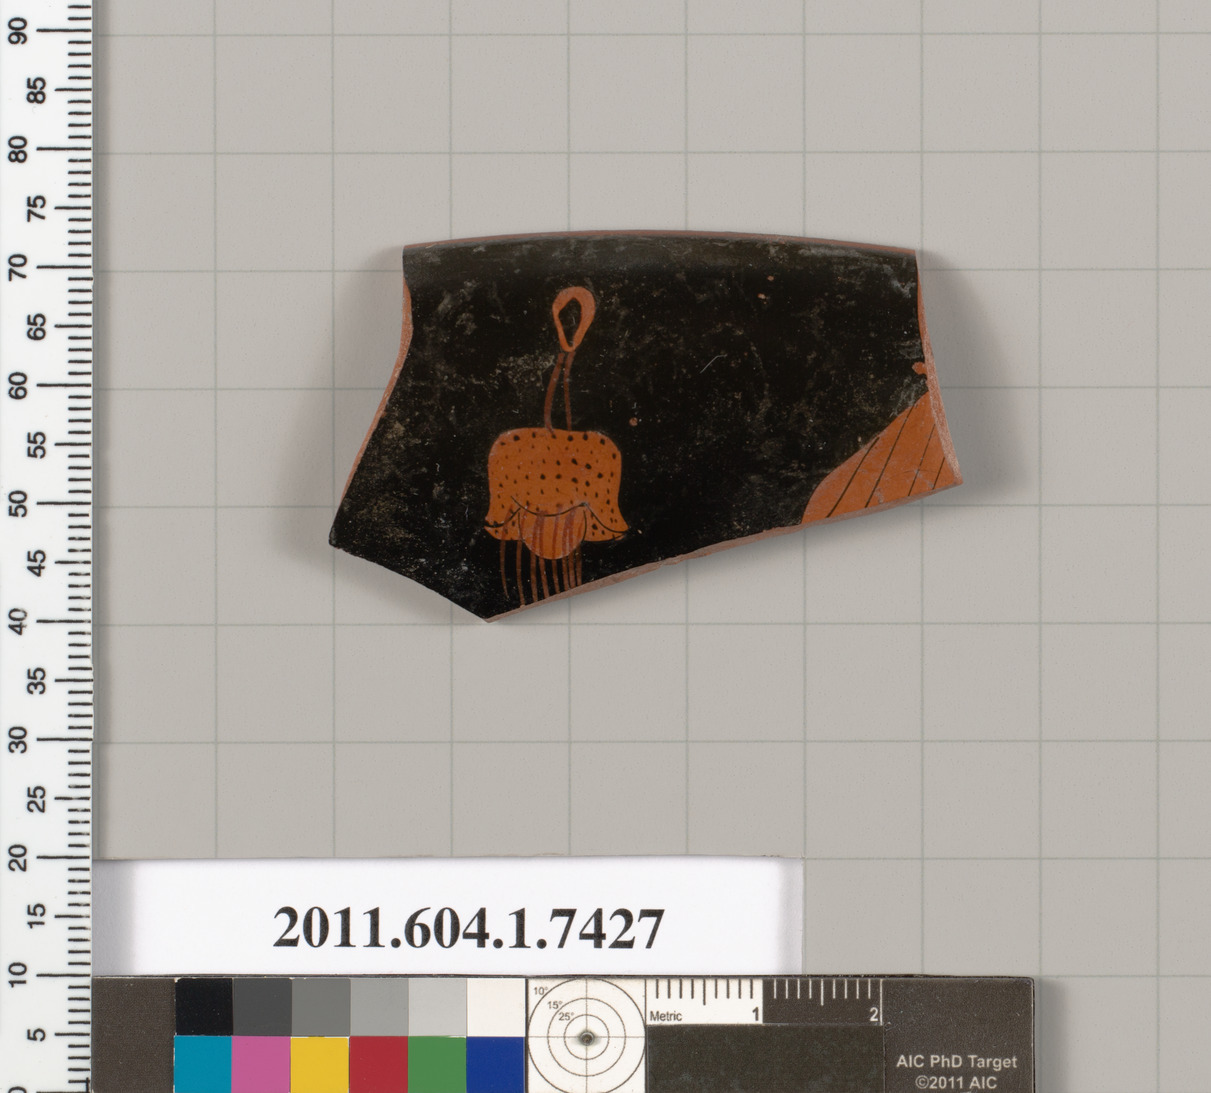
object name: kylix fragment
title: Terracotta rim fragment of a kylix (drinking cup)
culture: greek, attic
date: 490-470 BCE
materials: terracotta